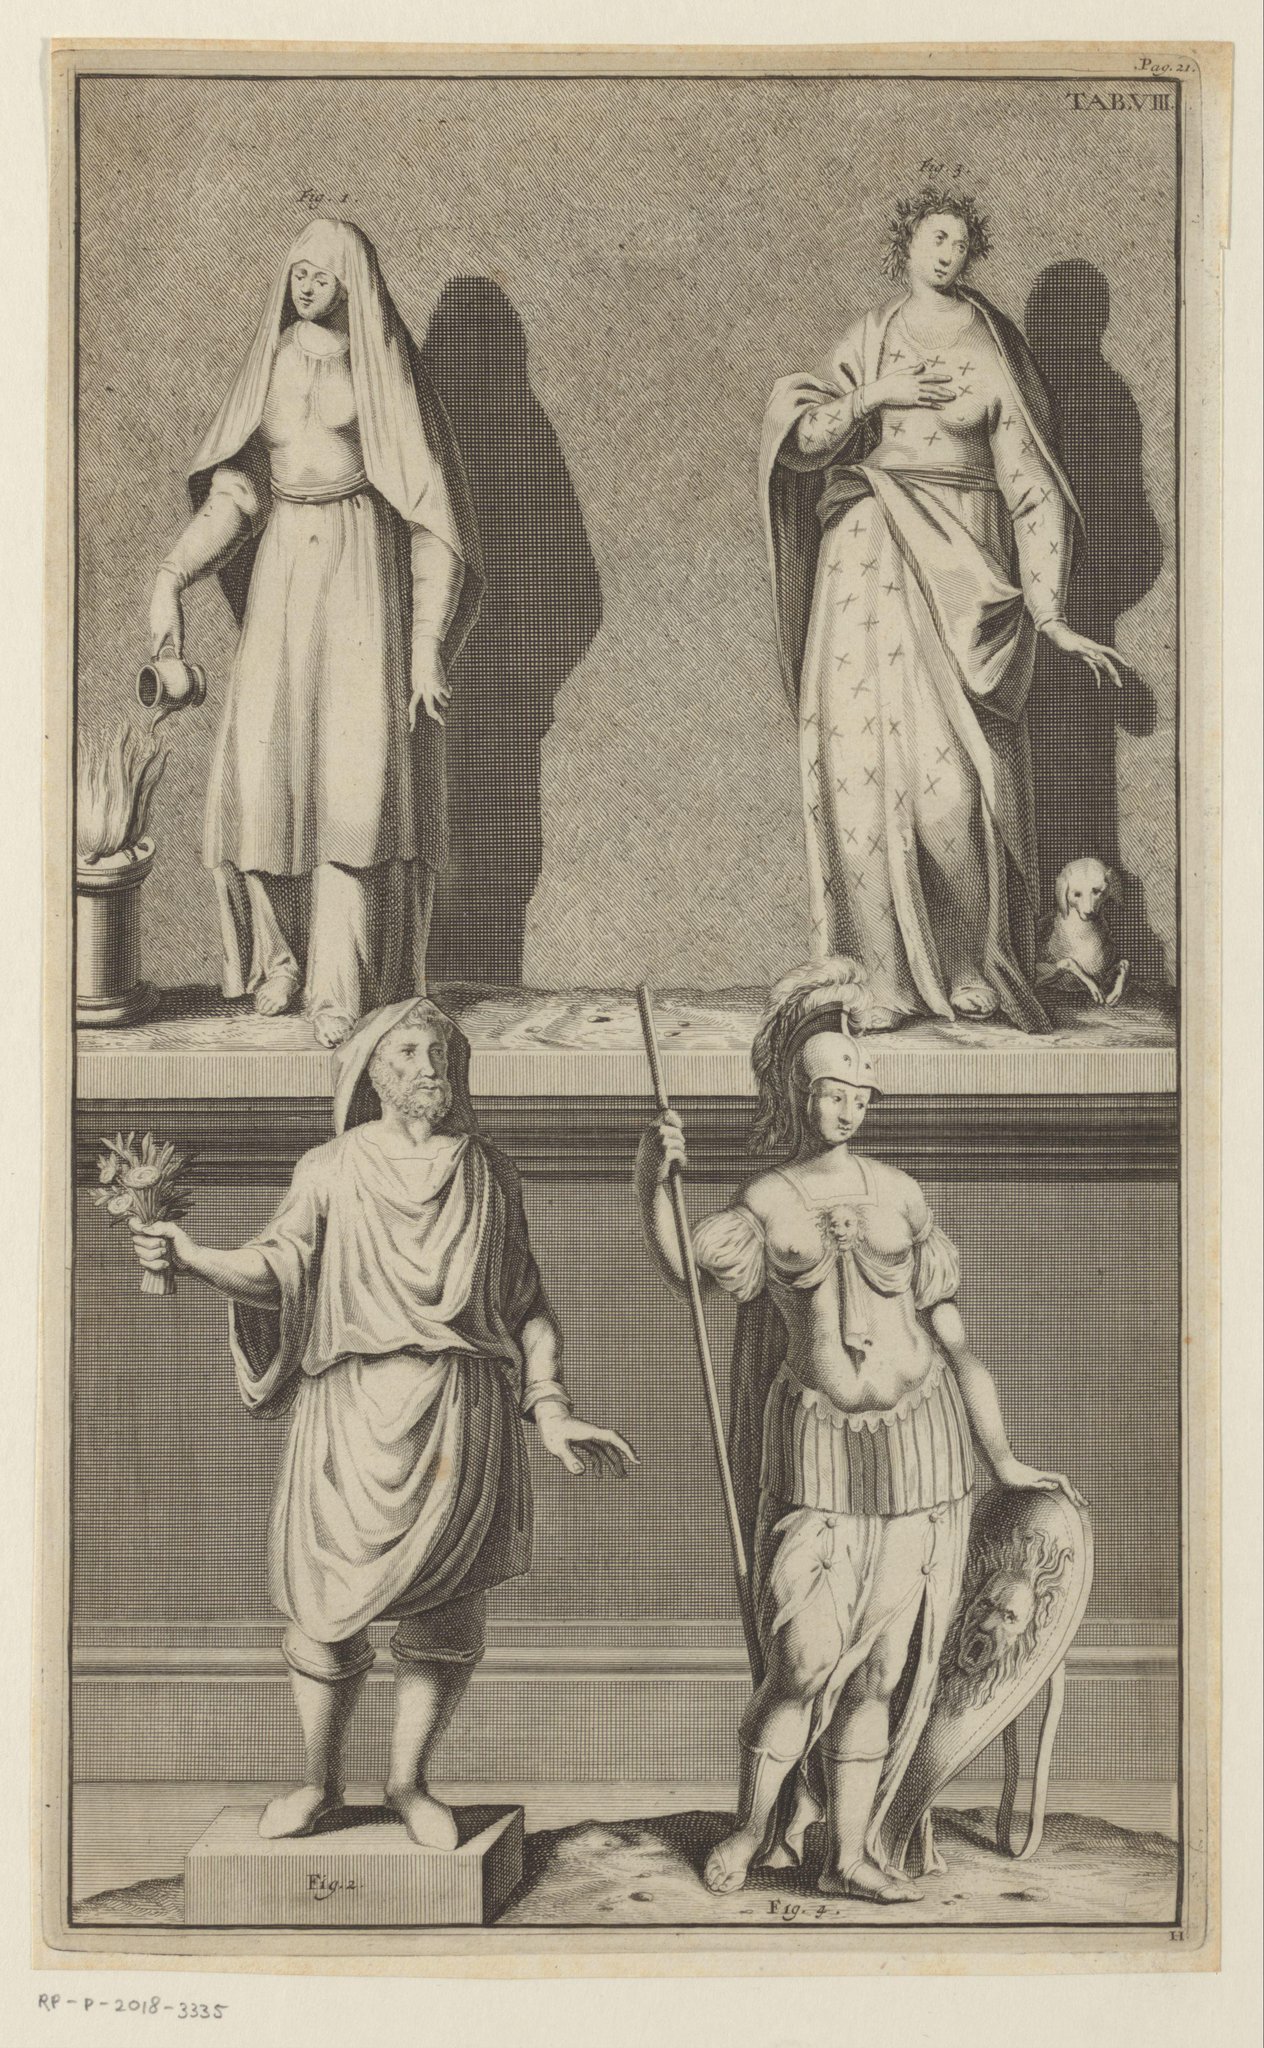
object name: print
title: Compositie met vier figuren, mogelijk standbeelden met Minerva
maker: Anonymous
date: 1700-1799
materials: paper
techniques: engraving, etching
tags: (story of) minerva (pallas, athena), sculpture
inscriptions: collector's mark: Lugt 2228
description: Prent uit een onbekend boek met objecten, kunstwerken en figuren uit de Romeinse geschiedenis en religie. Dit betreft een illustratie bij p. 21.